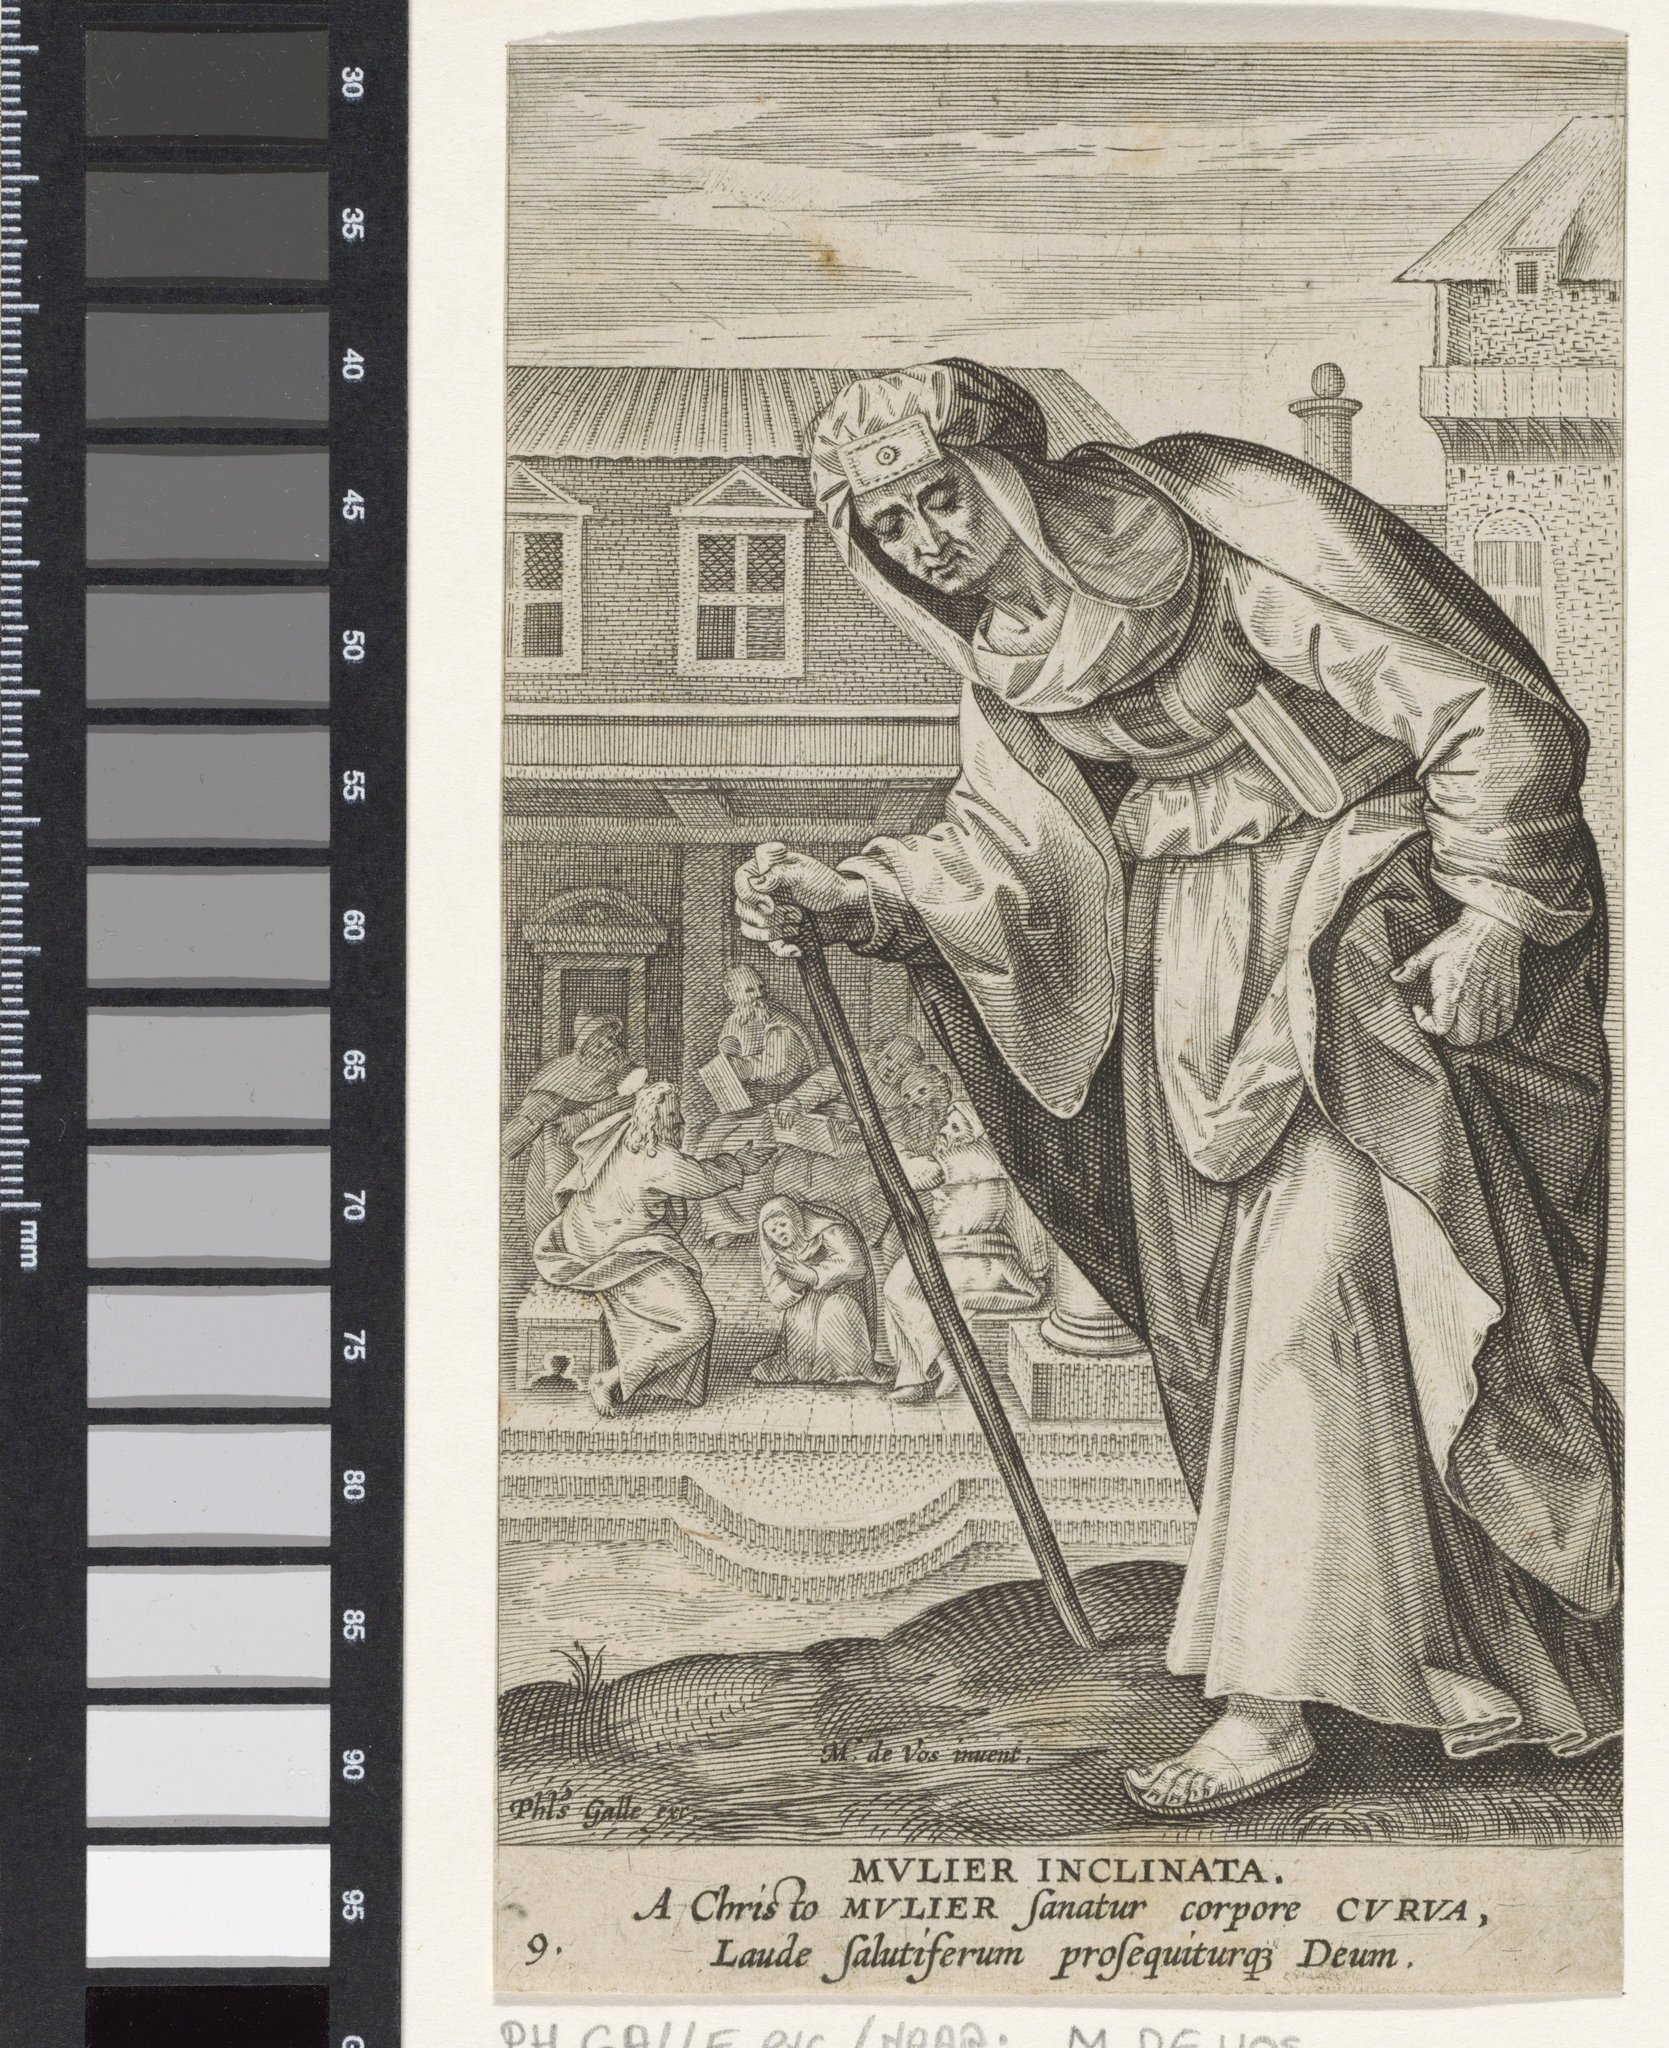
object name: print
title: Beroemde vrouwen uit het Nieuwe Testament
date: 1595-1599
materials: paper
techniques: engraving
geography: antwerp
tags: female persons from the new testament (not in biblical context), christ healing paralytics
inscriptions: collector's mark: Lugt 2228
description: Op de voorgrond een gebochelde vrouw. Op de achtergrond geneest Christus de gebochelde vrouw. De prent heeft een Latijns onderschrift en maakt deel uit van een prentserie met beroemde vrouwen uit het Nieuwe Testament.